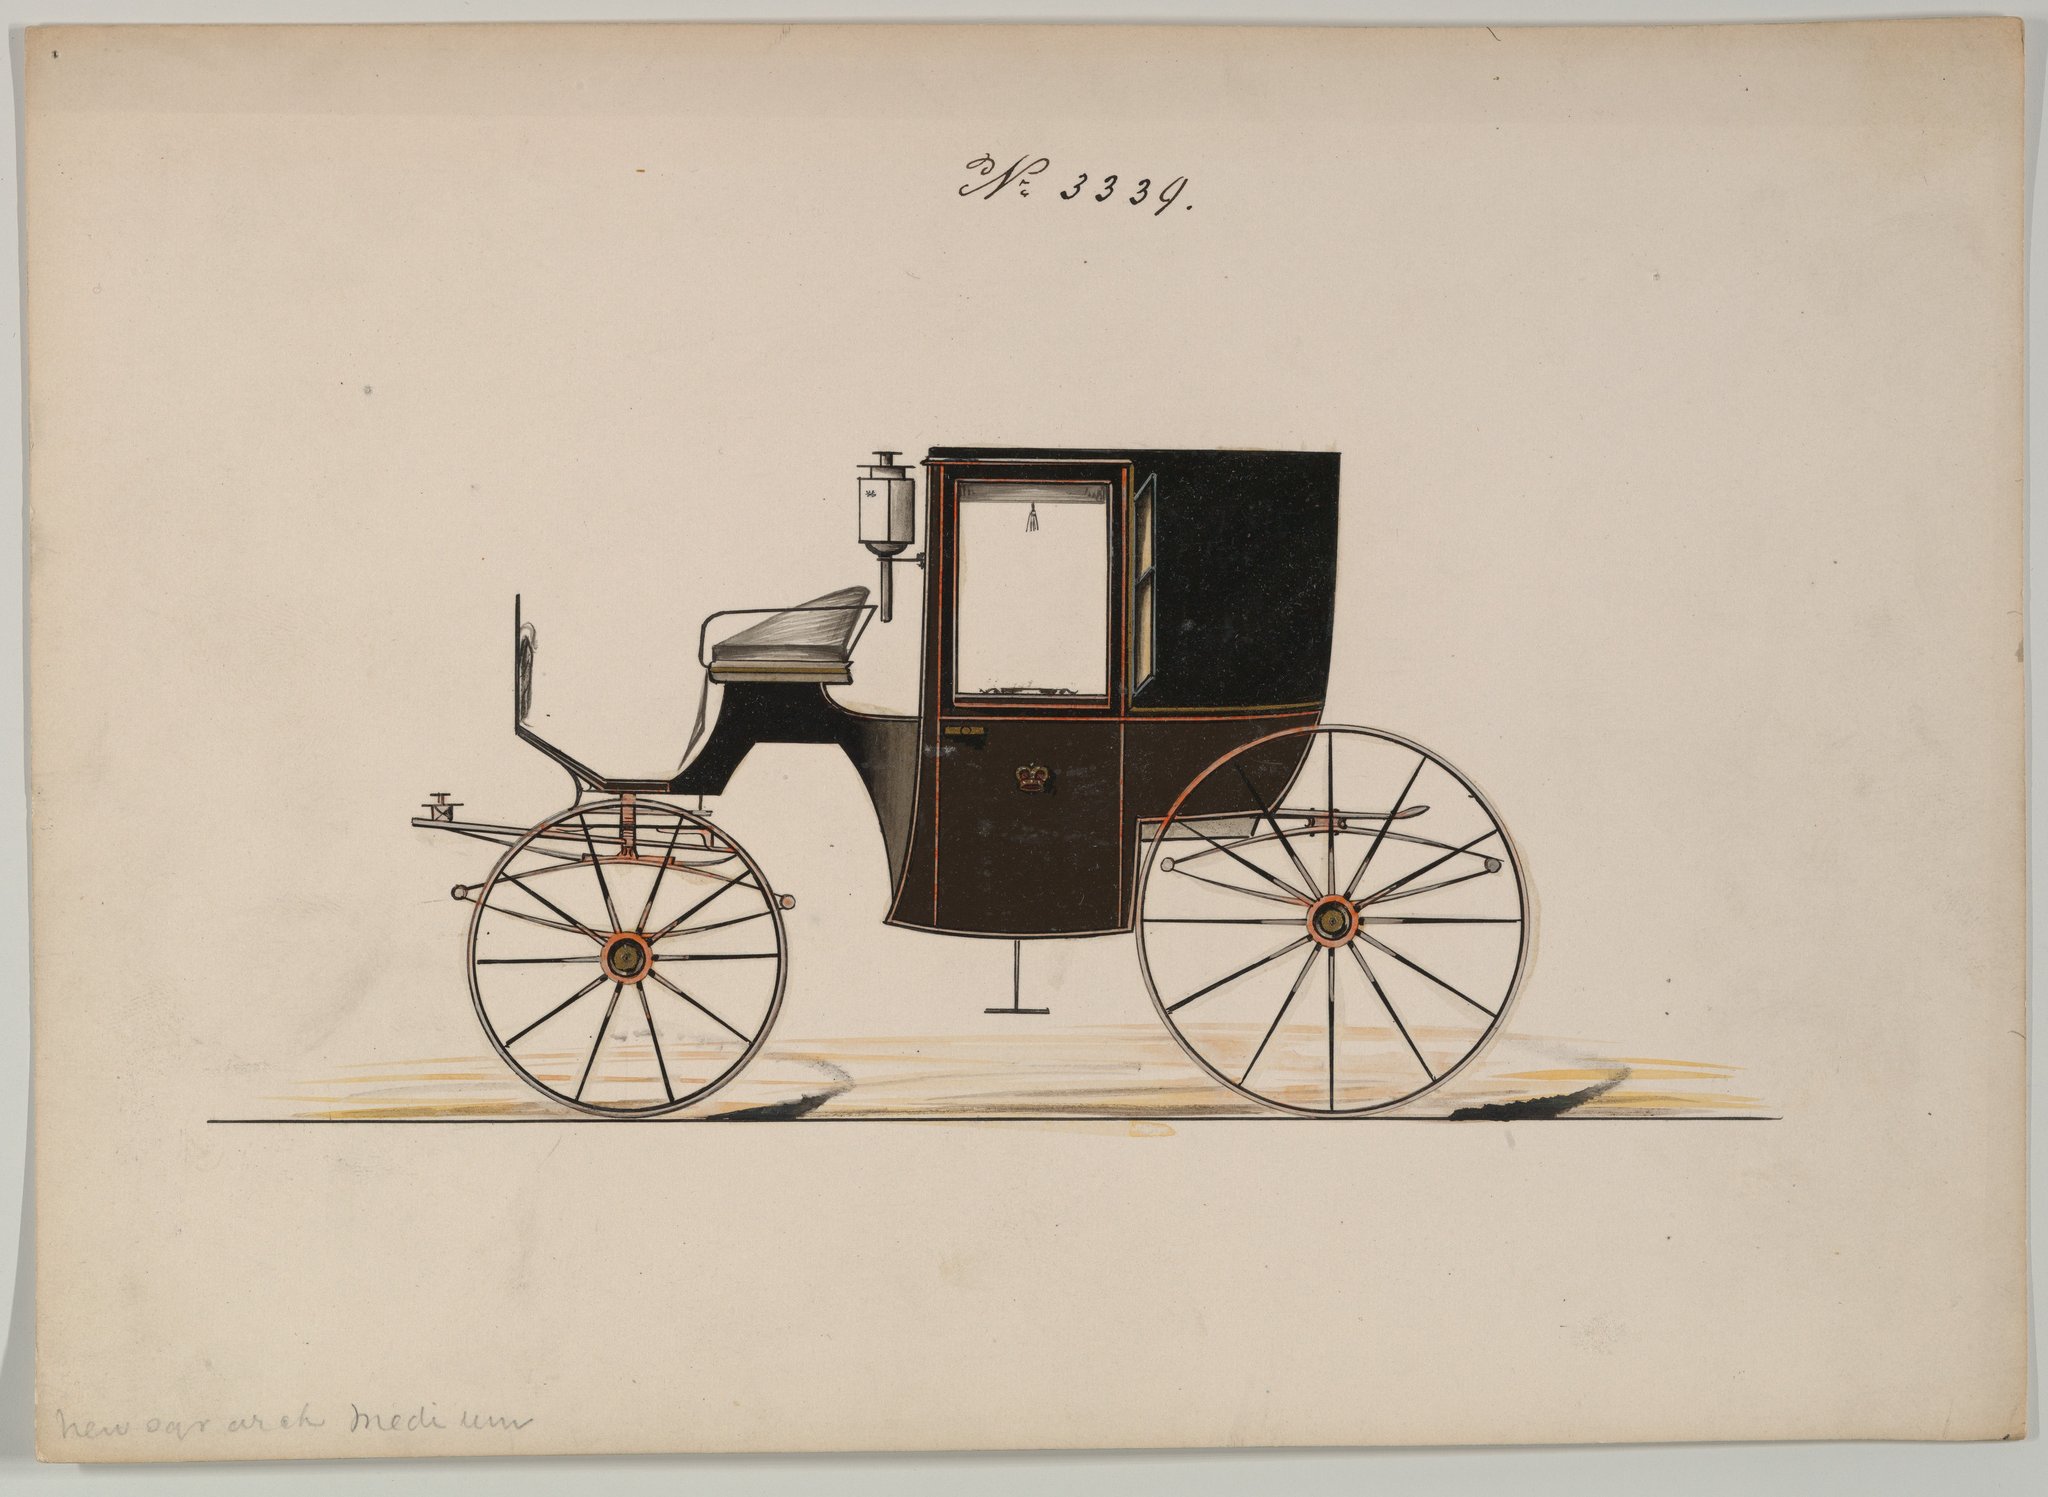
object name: drawing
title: Brougham #3339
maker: brewster & co.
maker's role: manufacturer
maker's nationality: american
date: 1877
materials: gouache, gum arabic, ink, watercolor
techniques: pen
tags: carriages